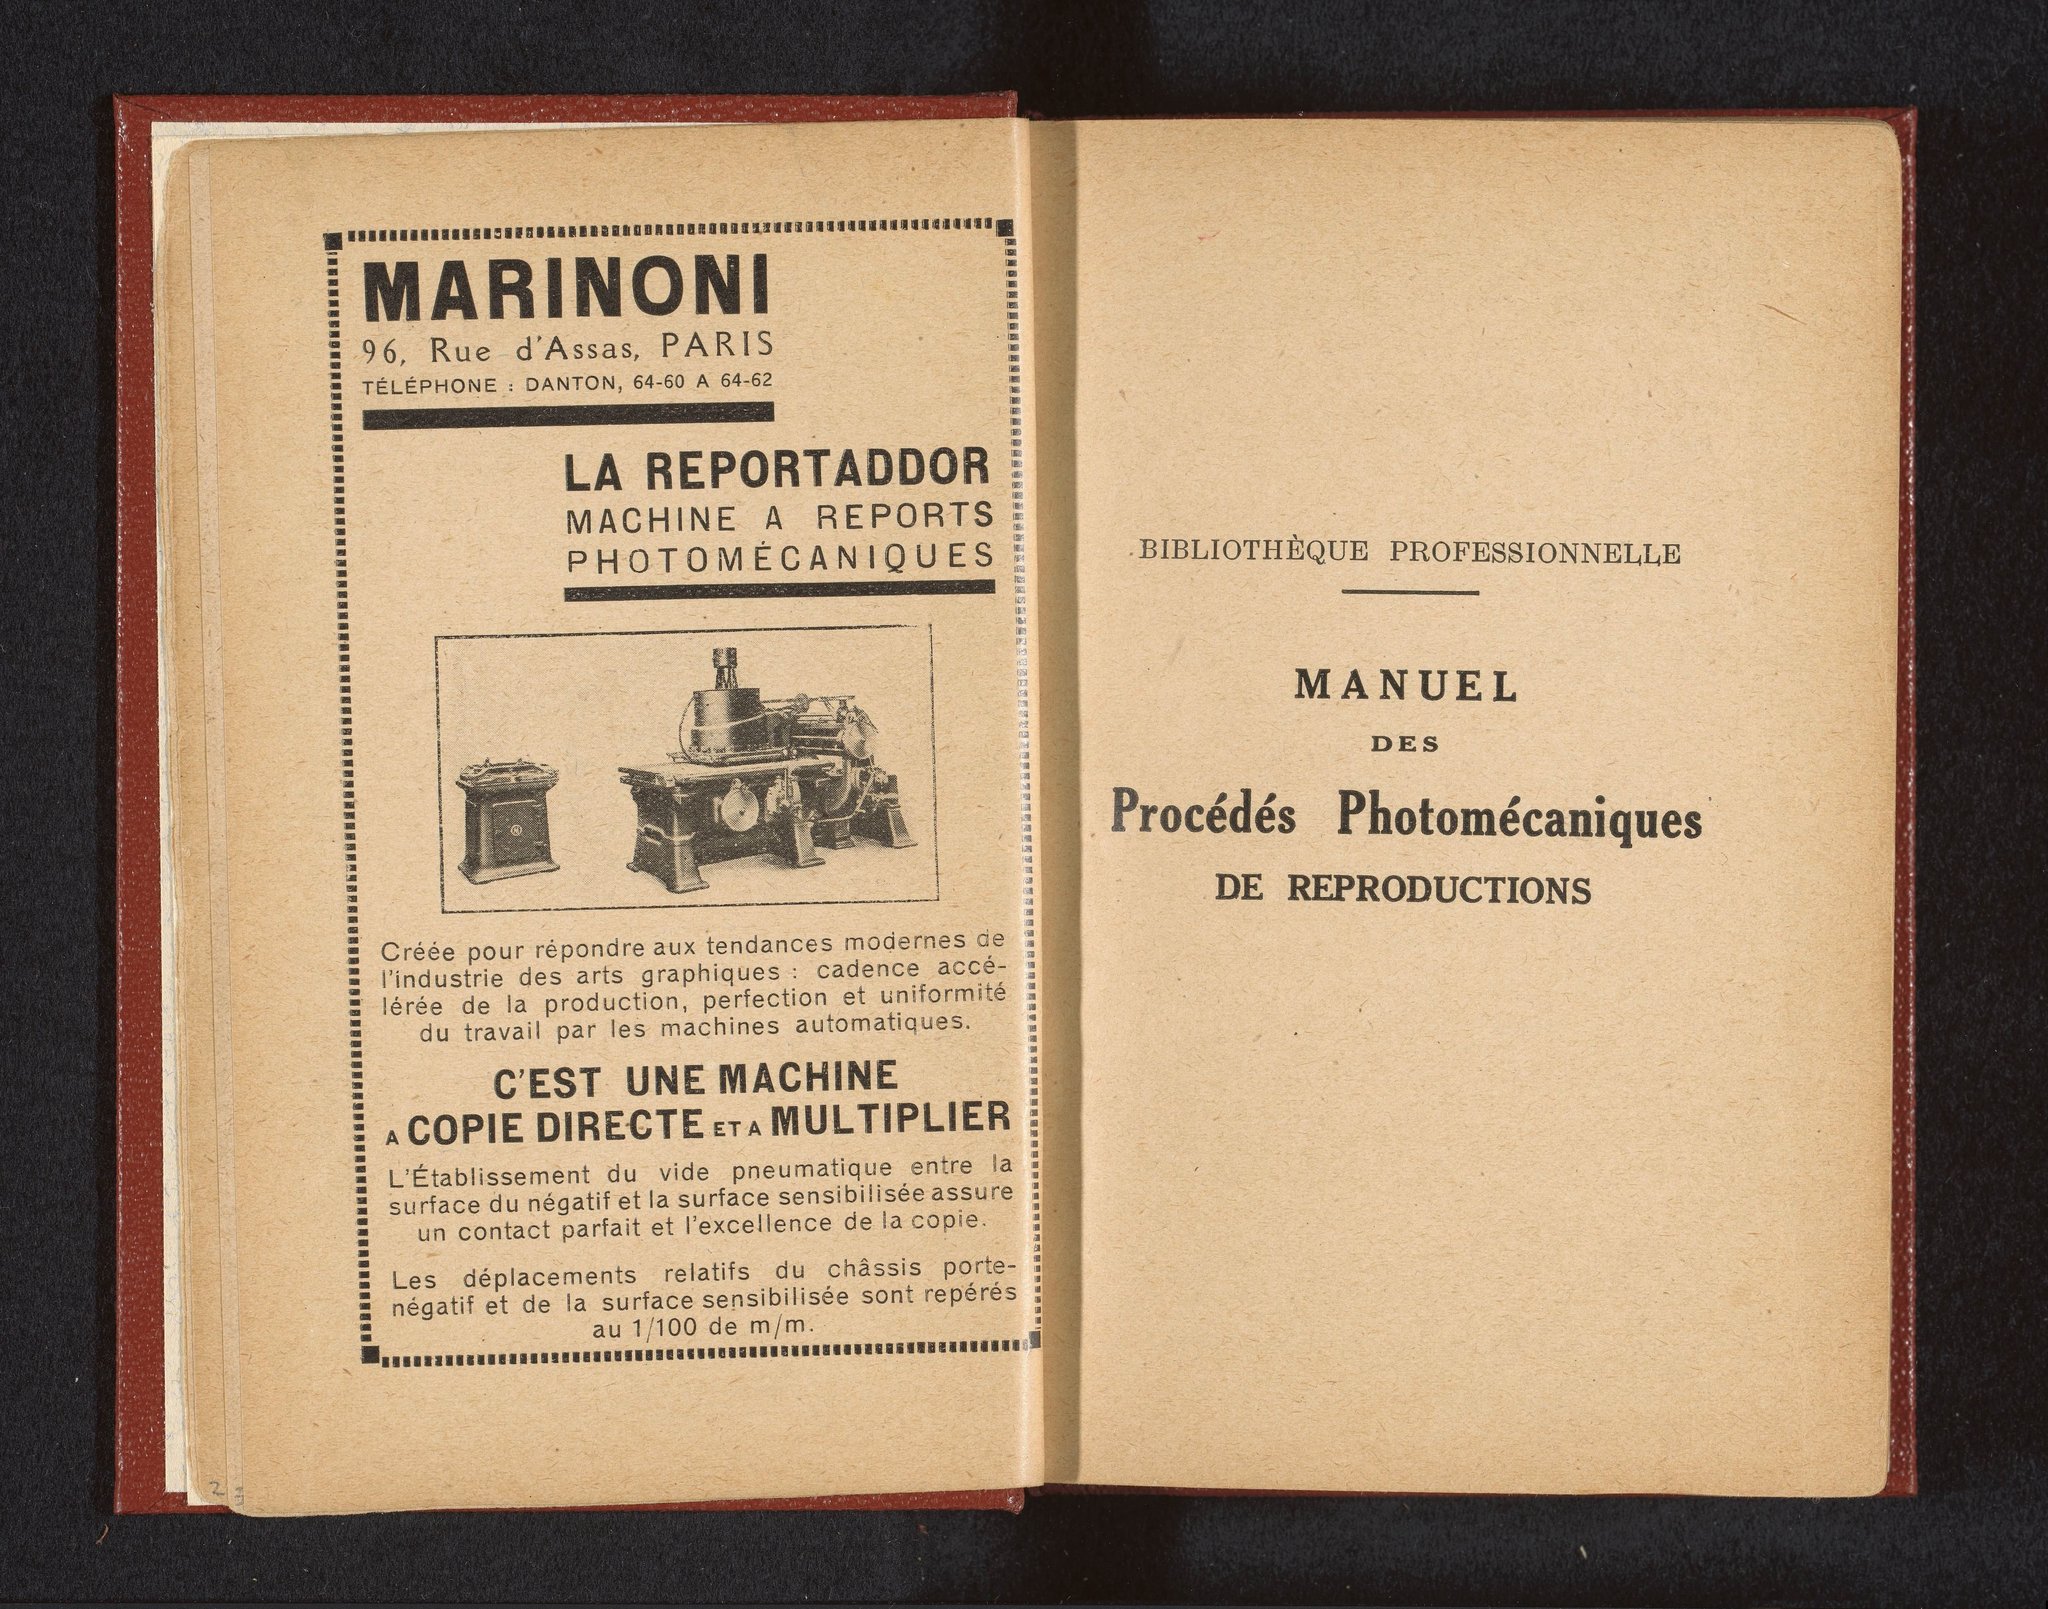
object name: photomechanical print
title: Apparaat om fotomechanische reproducties te maken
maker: Anonymous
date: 1922-1932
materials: paper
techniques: autotype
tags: photographic apparatus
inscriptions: inscription: ‘Marinoni 96, Rue d'Assas, Paris Téléphone: danton, 64-60 A 64-62 La reportaddor Machine a reports photomécaniques’